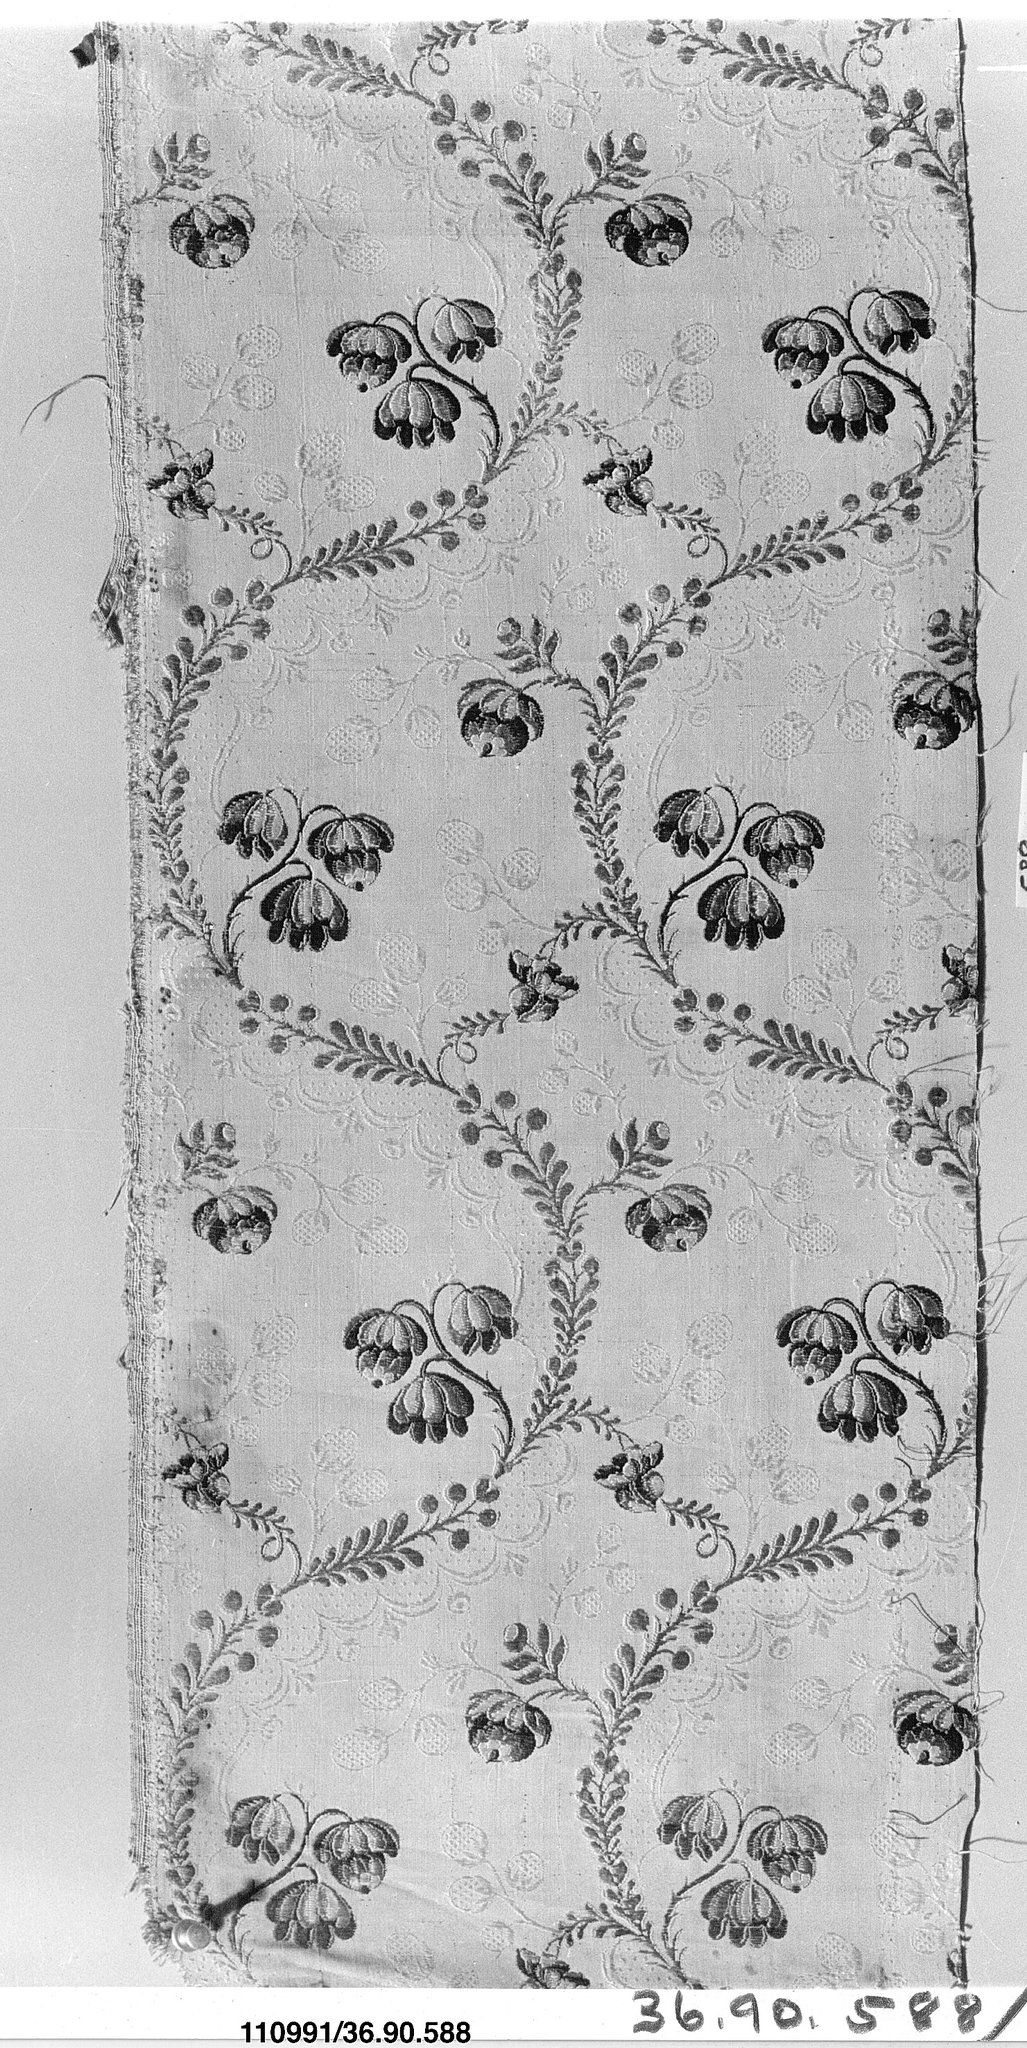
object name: piece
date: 1734-1766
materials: silk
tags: flowers